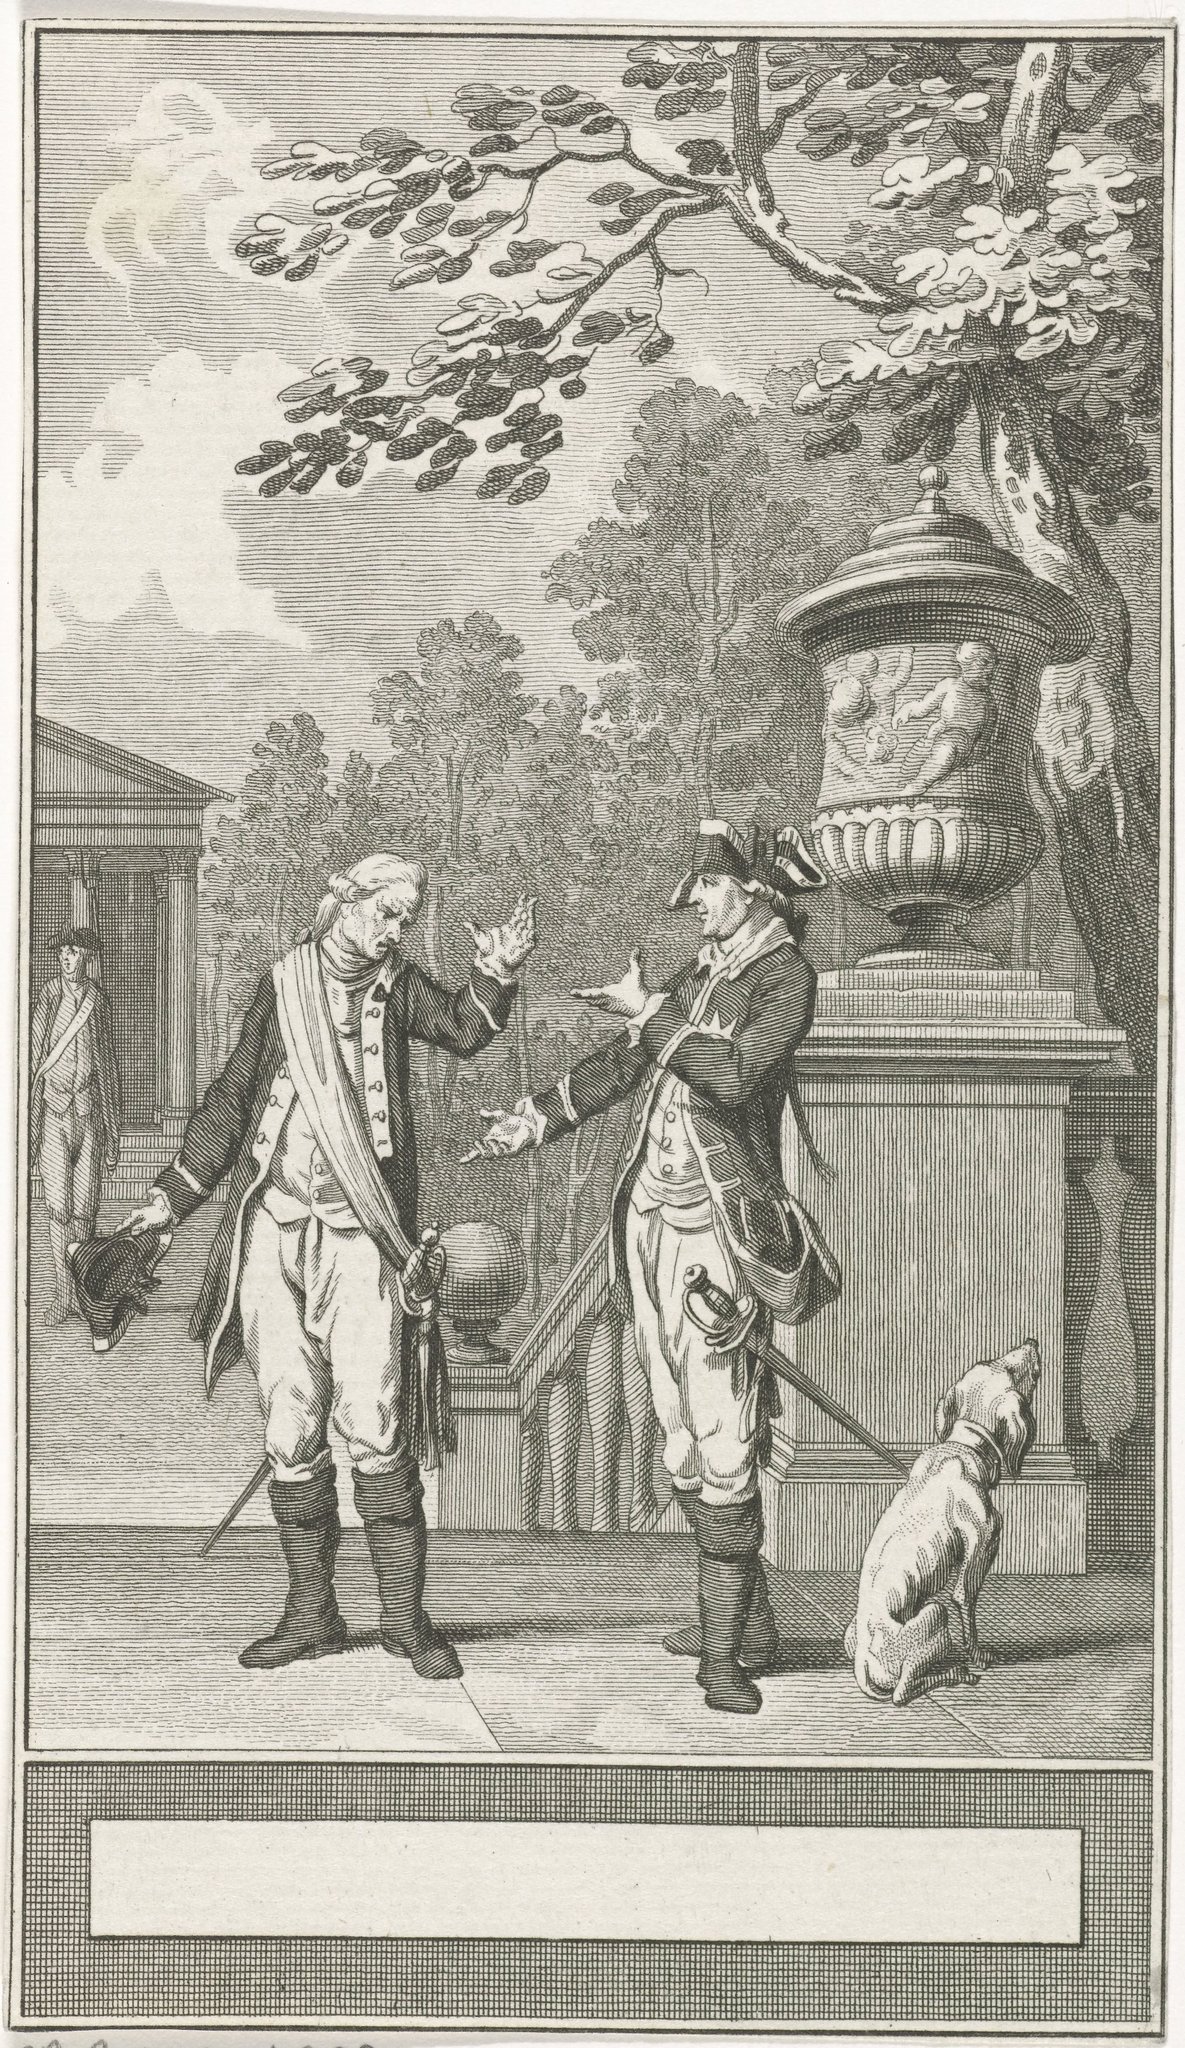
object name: print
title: Vrome generaal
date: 1778-1785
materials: paper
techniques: etching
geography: amsterdam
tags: commander-in-chief, general, marshal, prince, dog, garden vase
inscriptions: collector's mark: Lugt 2228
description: Latere staat bij: Gellert, Christian Fürchtegott. Fabelen en vertelsels. 3 dln. Amsterdam: Pieter Meyer, 1772-1774. De prenten bij deze publicatie werden later uitgegeven. De exemplaren uitgegeven door de weduwe Jacobus Loveringh & Johannes Allart tussen 1777 en 1778, de exemplaren uitgegeven door alleen Johannes Allart tussen 1778 en 1785.